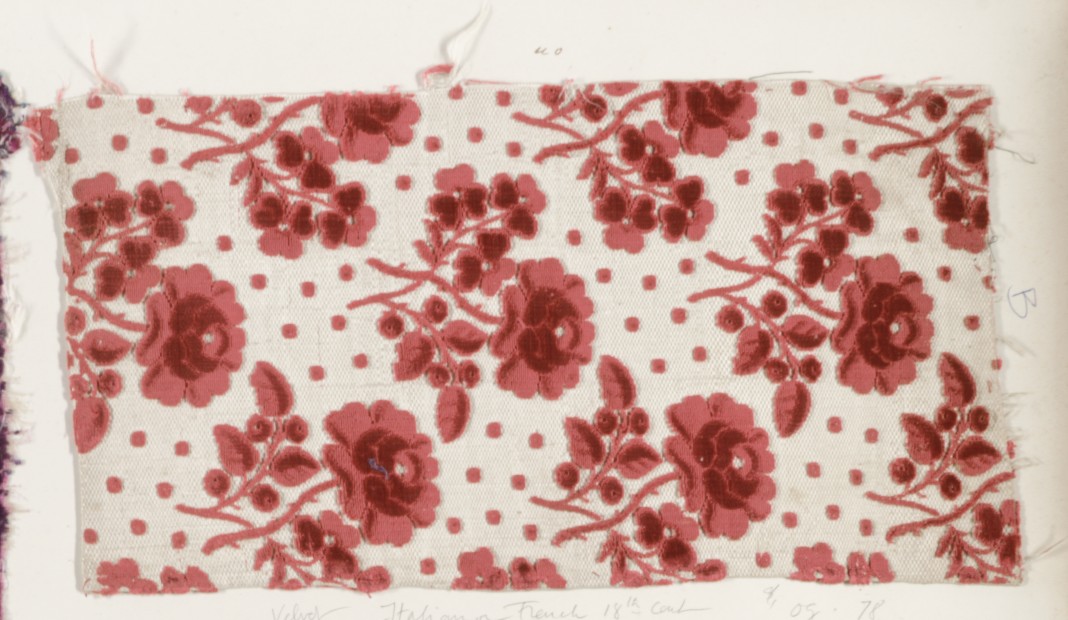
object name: fragment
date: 1701-1800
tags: flowers,leaves